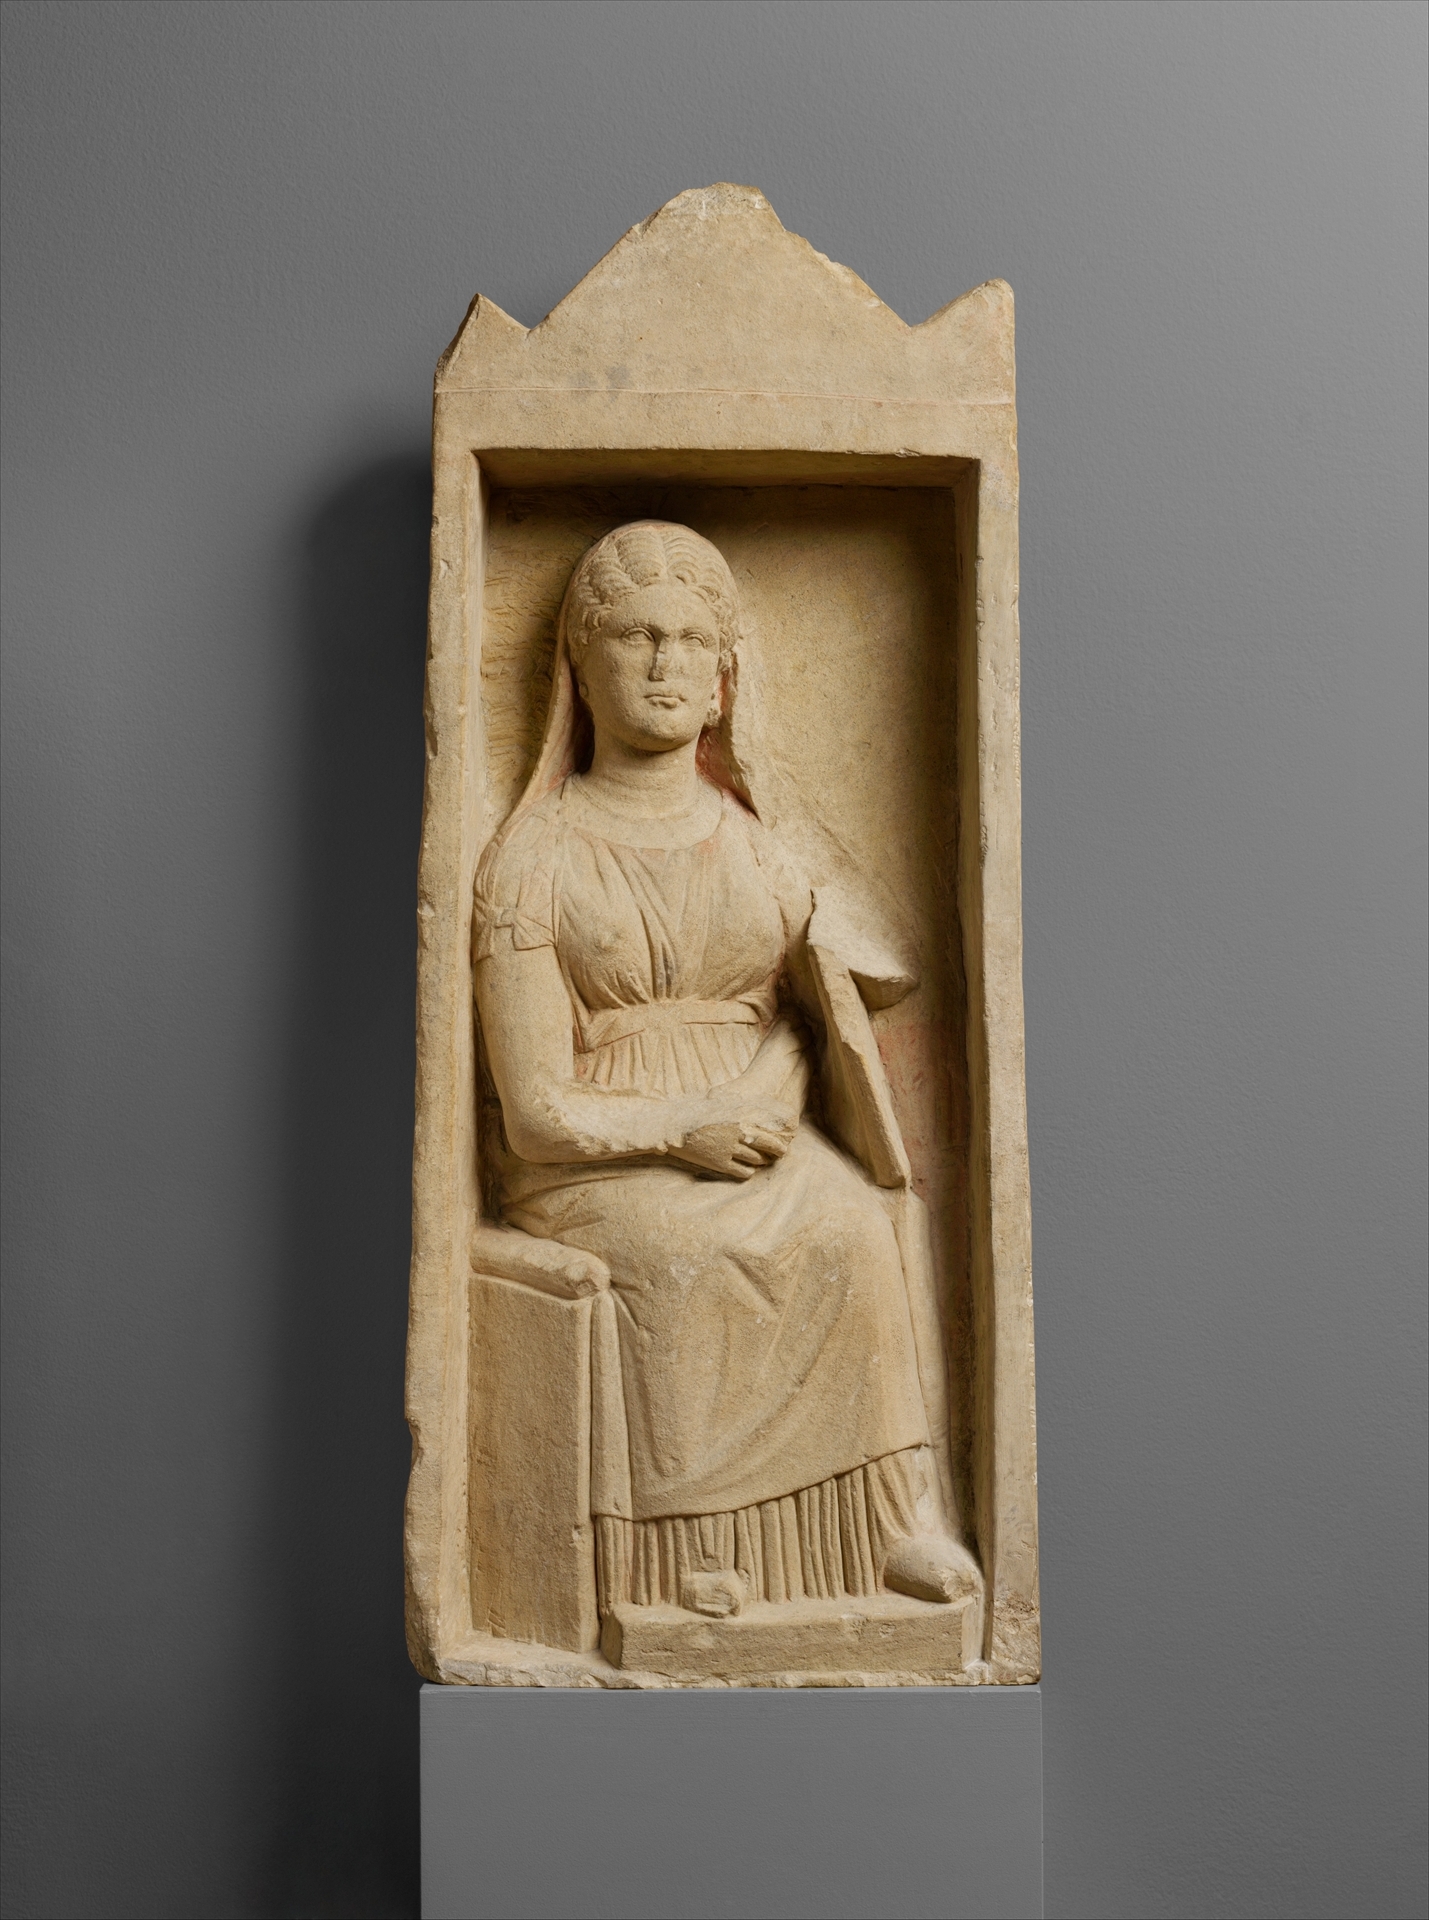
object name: grave stele of a woman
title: Limestone funerary monument with a seated woman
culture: cypriot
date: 200-1 BCE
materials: limestone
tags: women